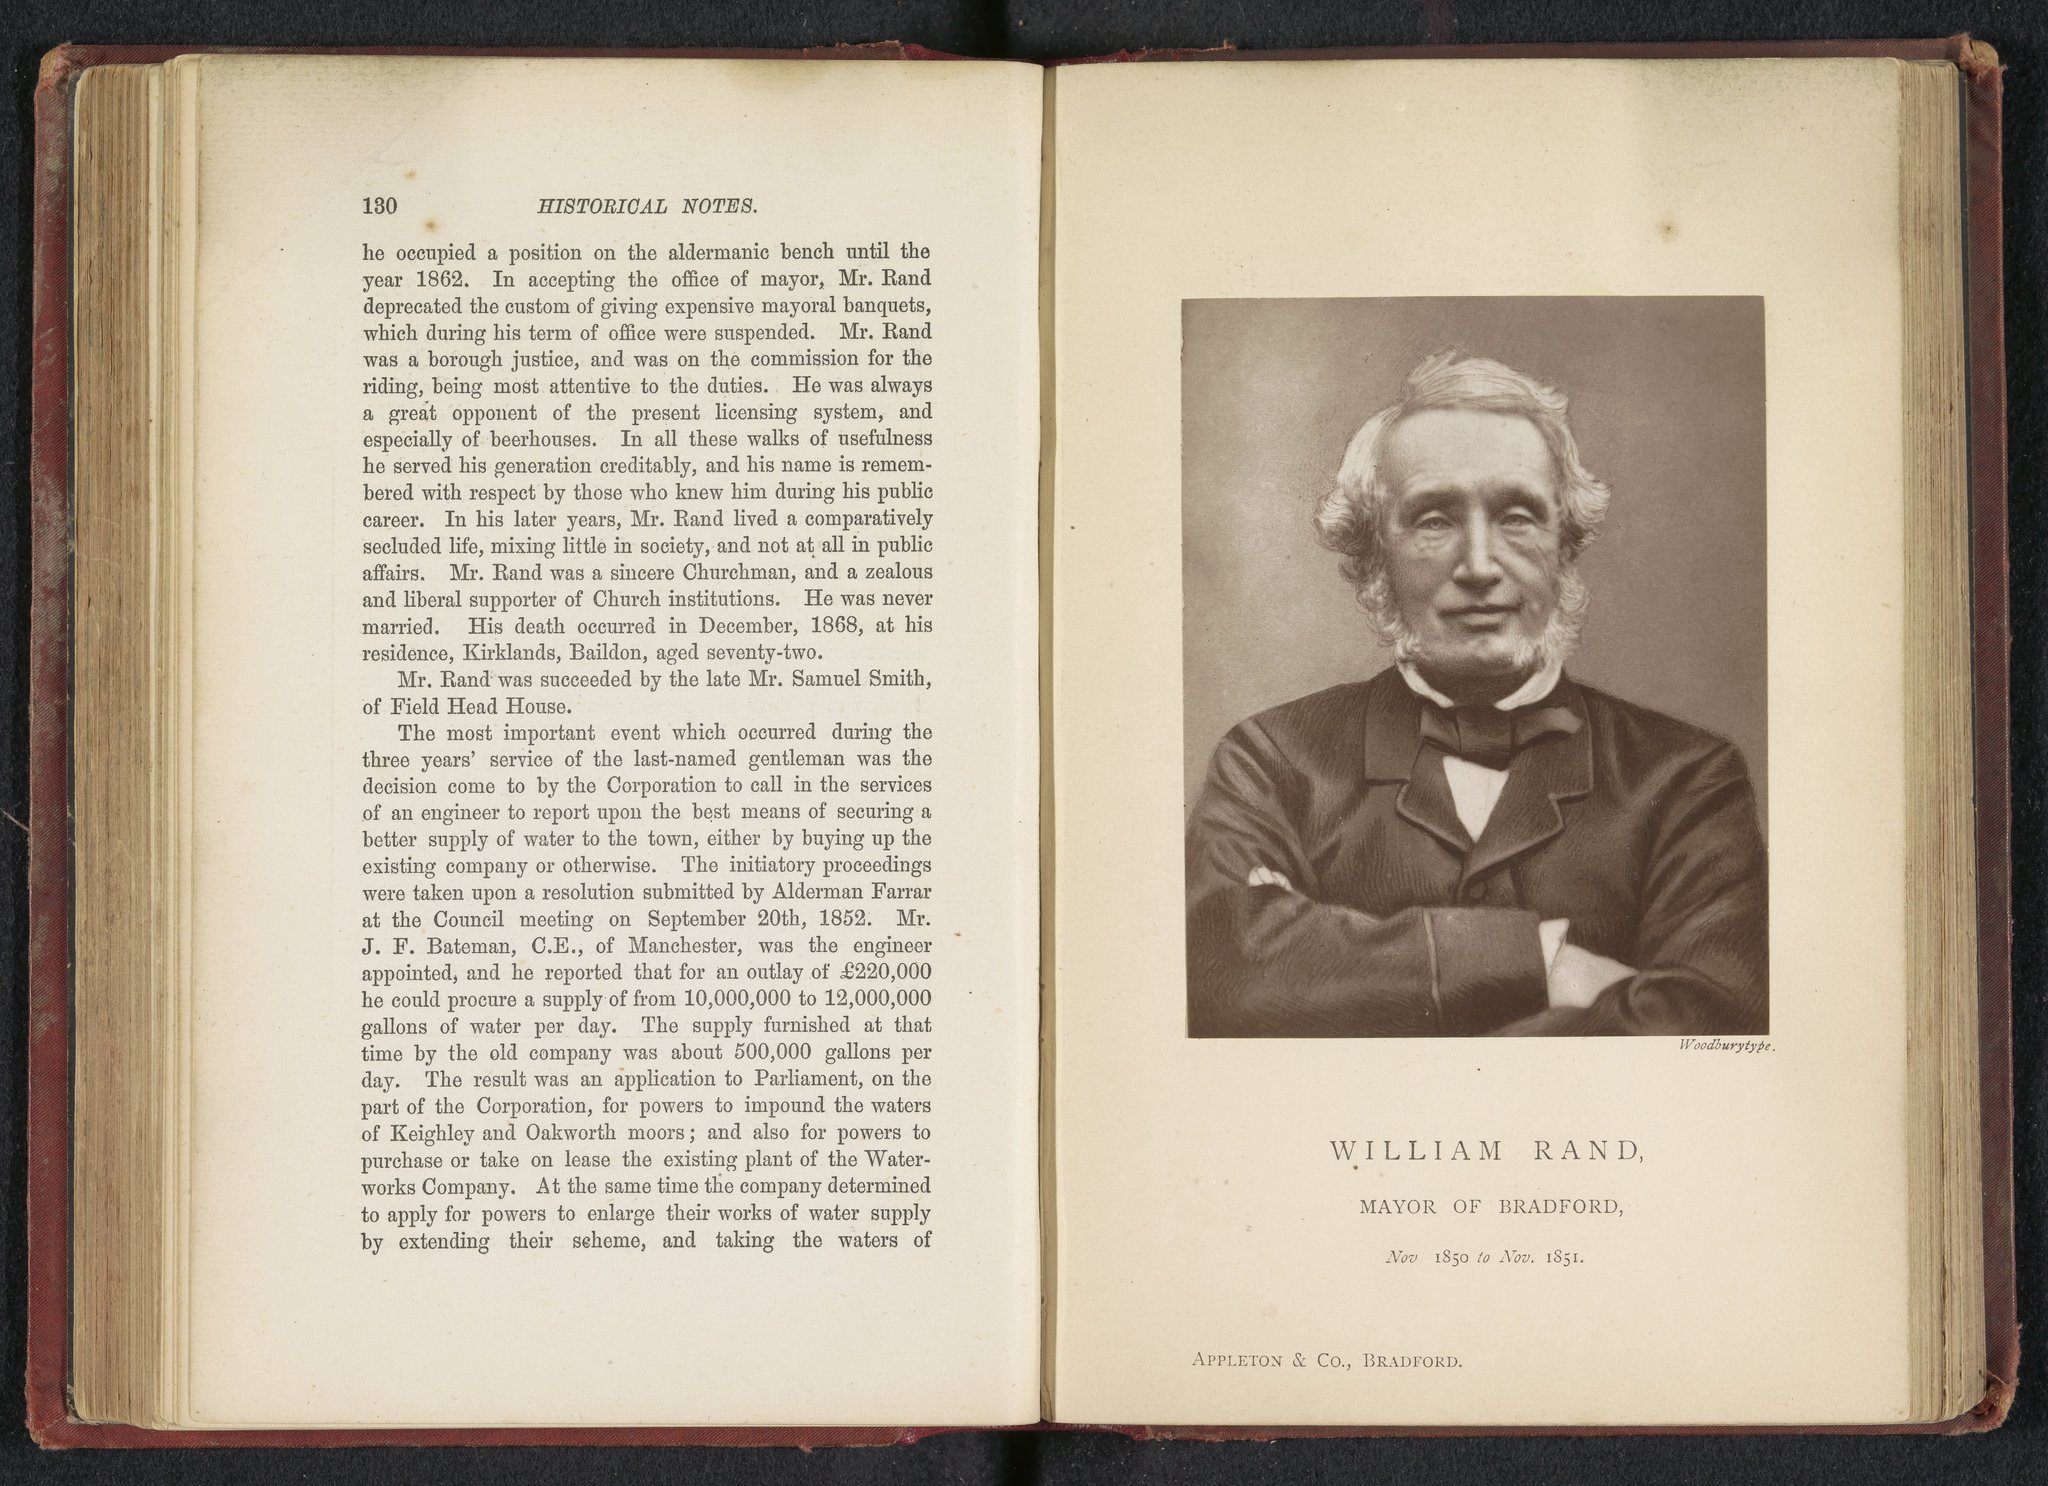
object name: photomechanical print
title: William Rand, mayor of Bradford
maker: Anonymous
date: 1871-1881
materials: paper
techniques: woodburytype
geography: bradford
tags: historical persons (portraits and scenes from the life) (+ (full) bust portrait)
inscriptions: inscription: ‘Nov. 1850 to Nov. 1851.’